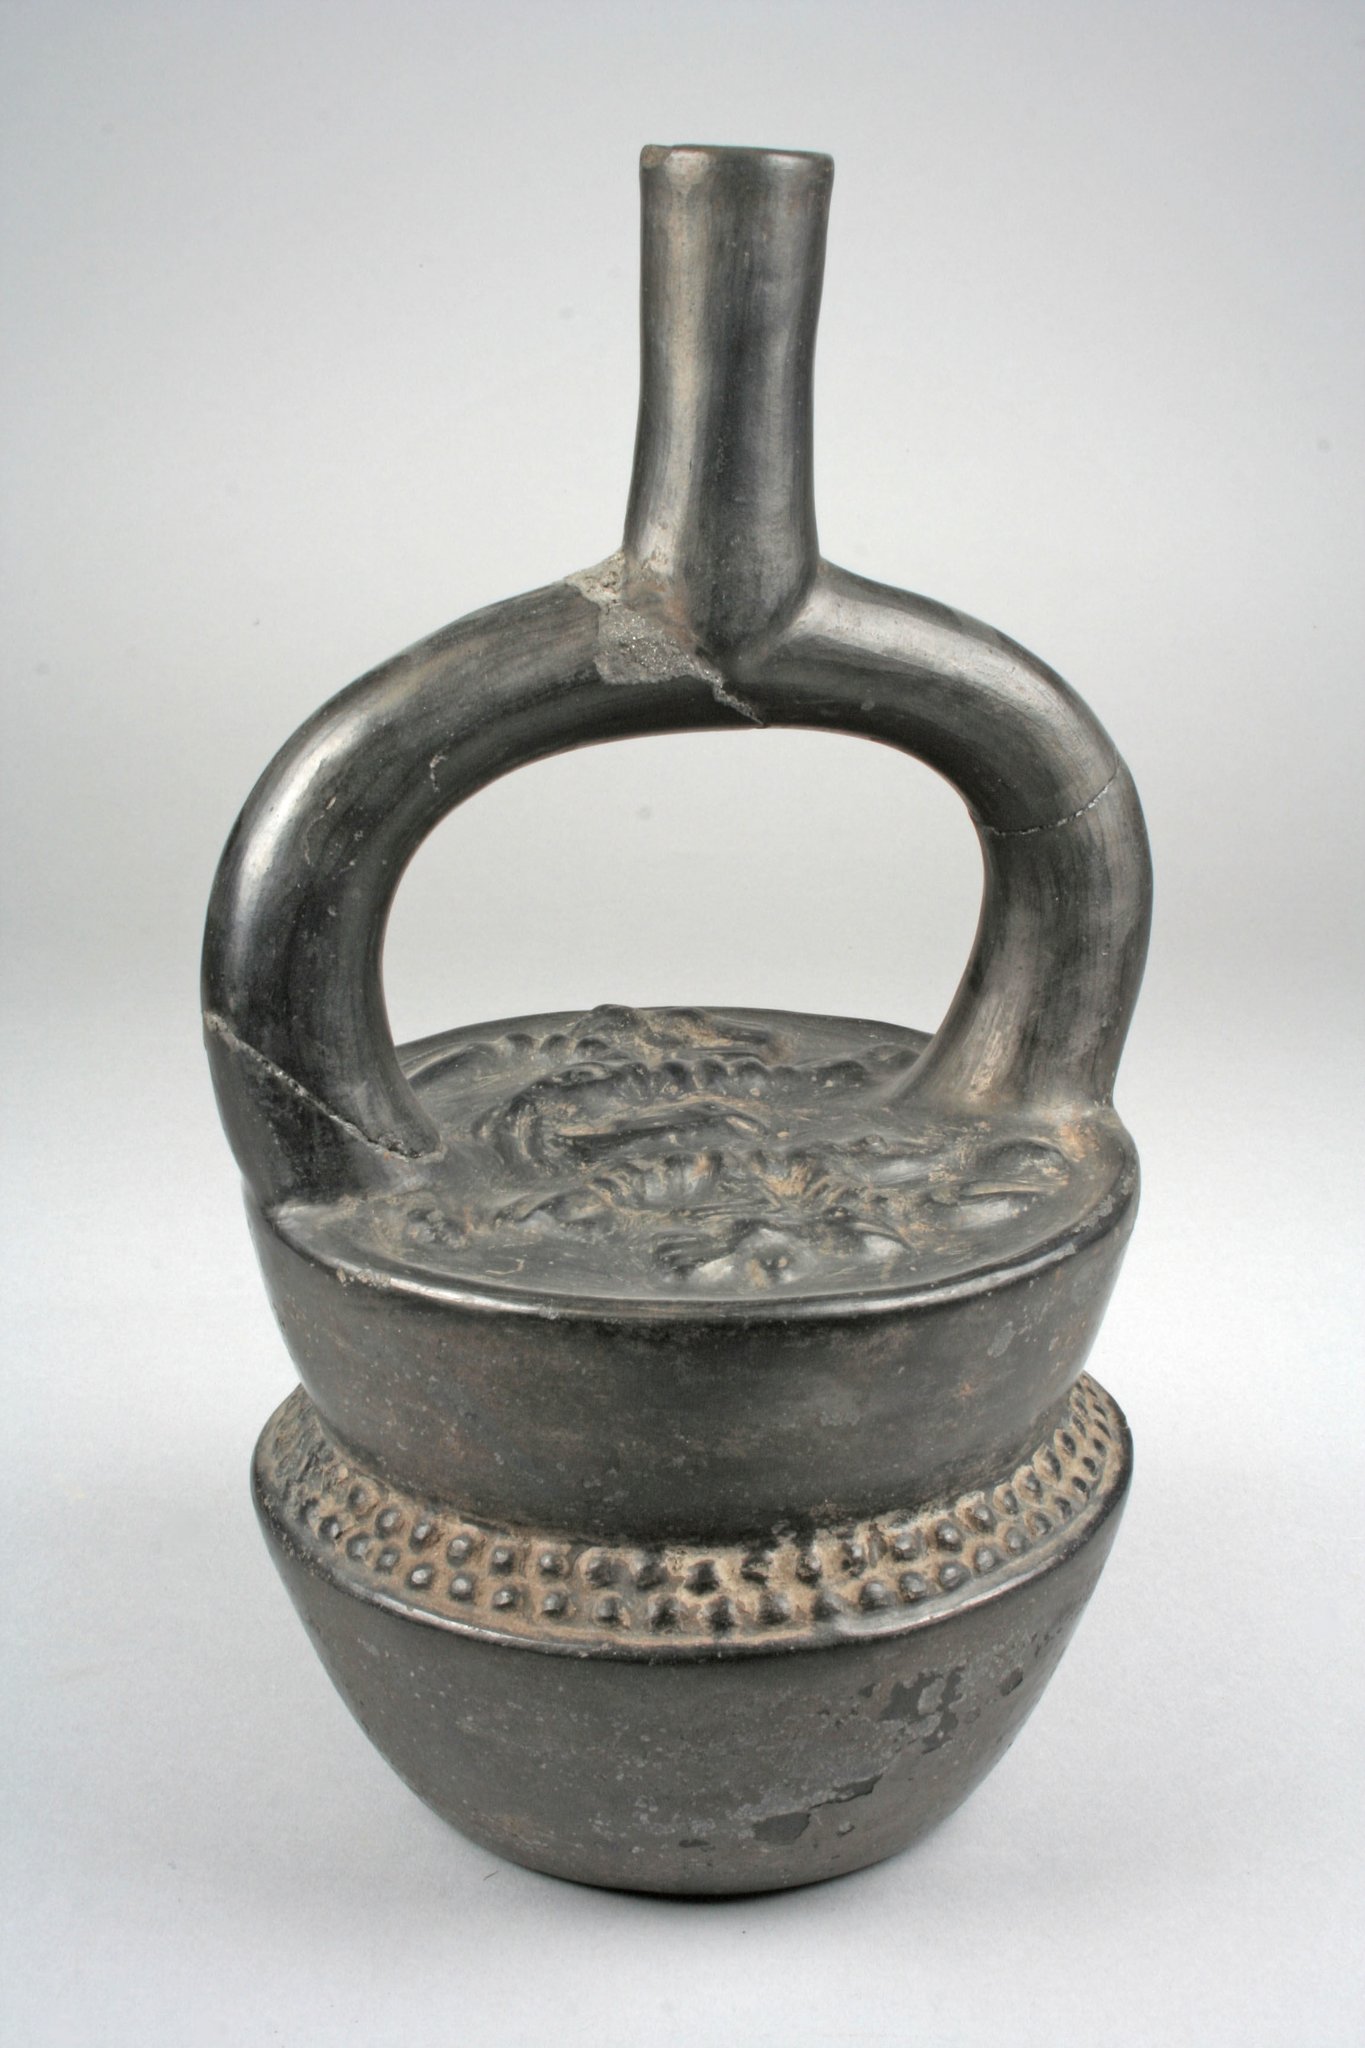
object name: bottle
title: Stirrup Spout Bottle with Stacked Containers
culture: moche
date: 101-600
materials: ceramic, pigment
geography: peru